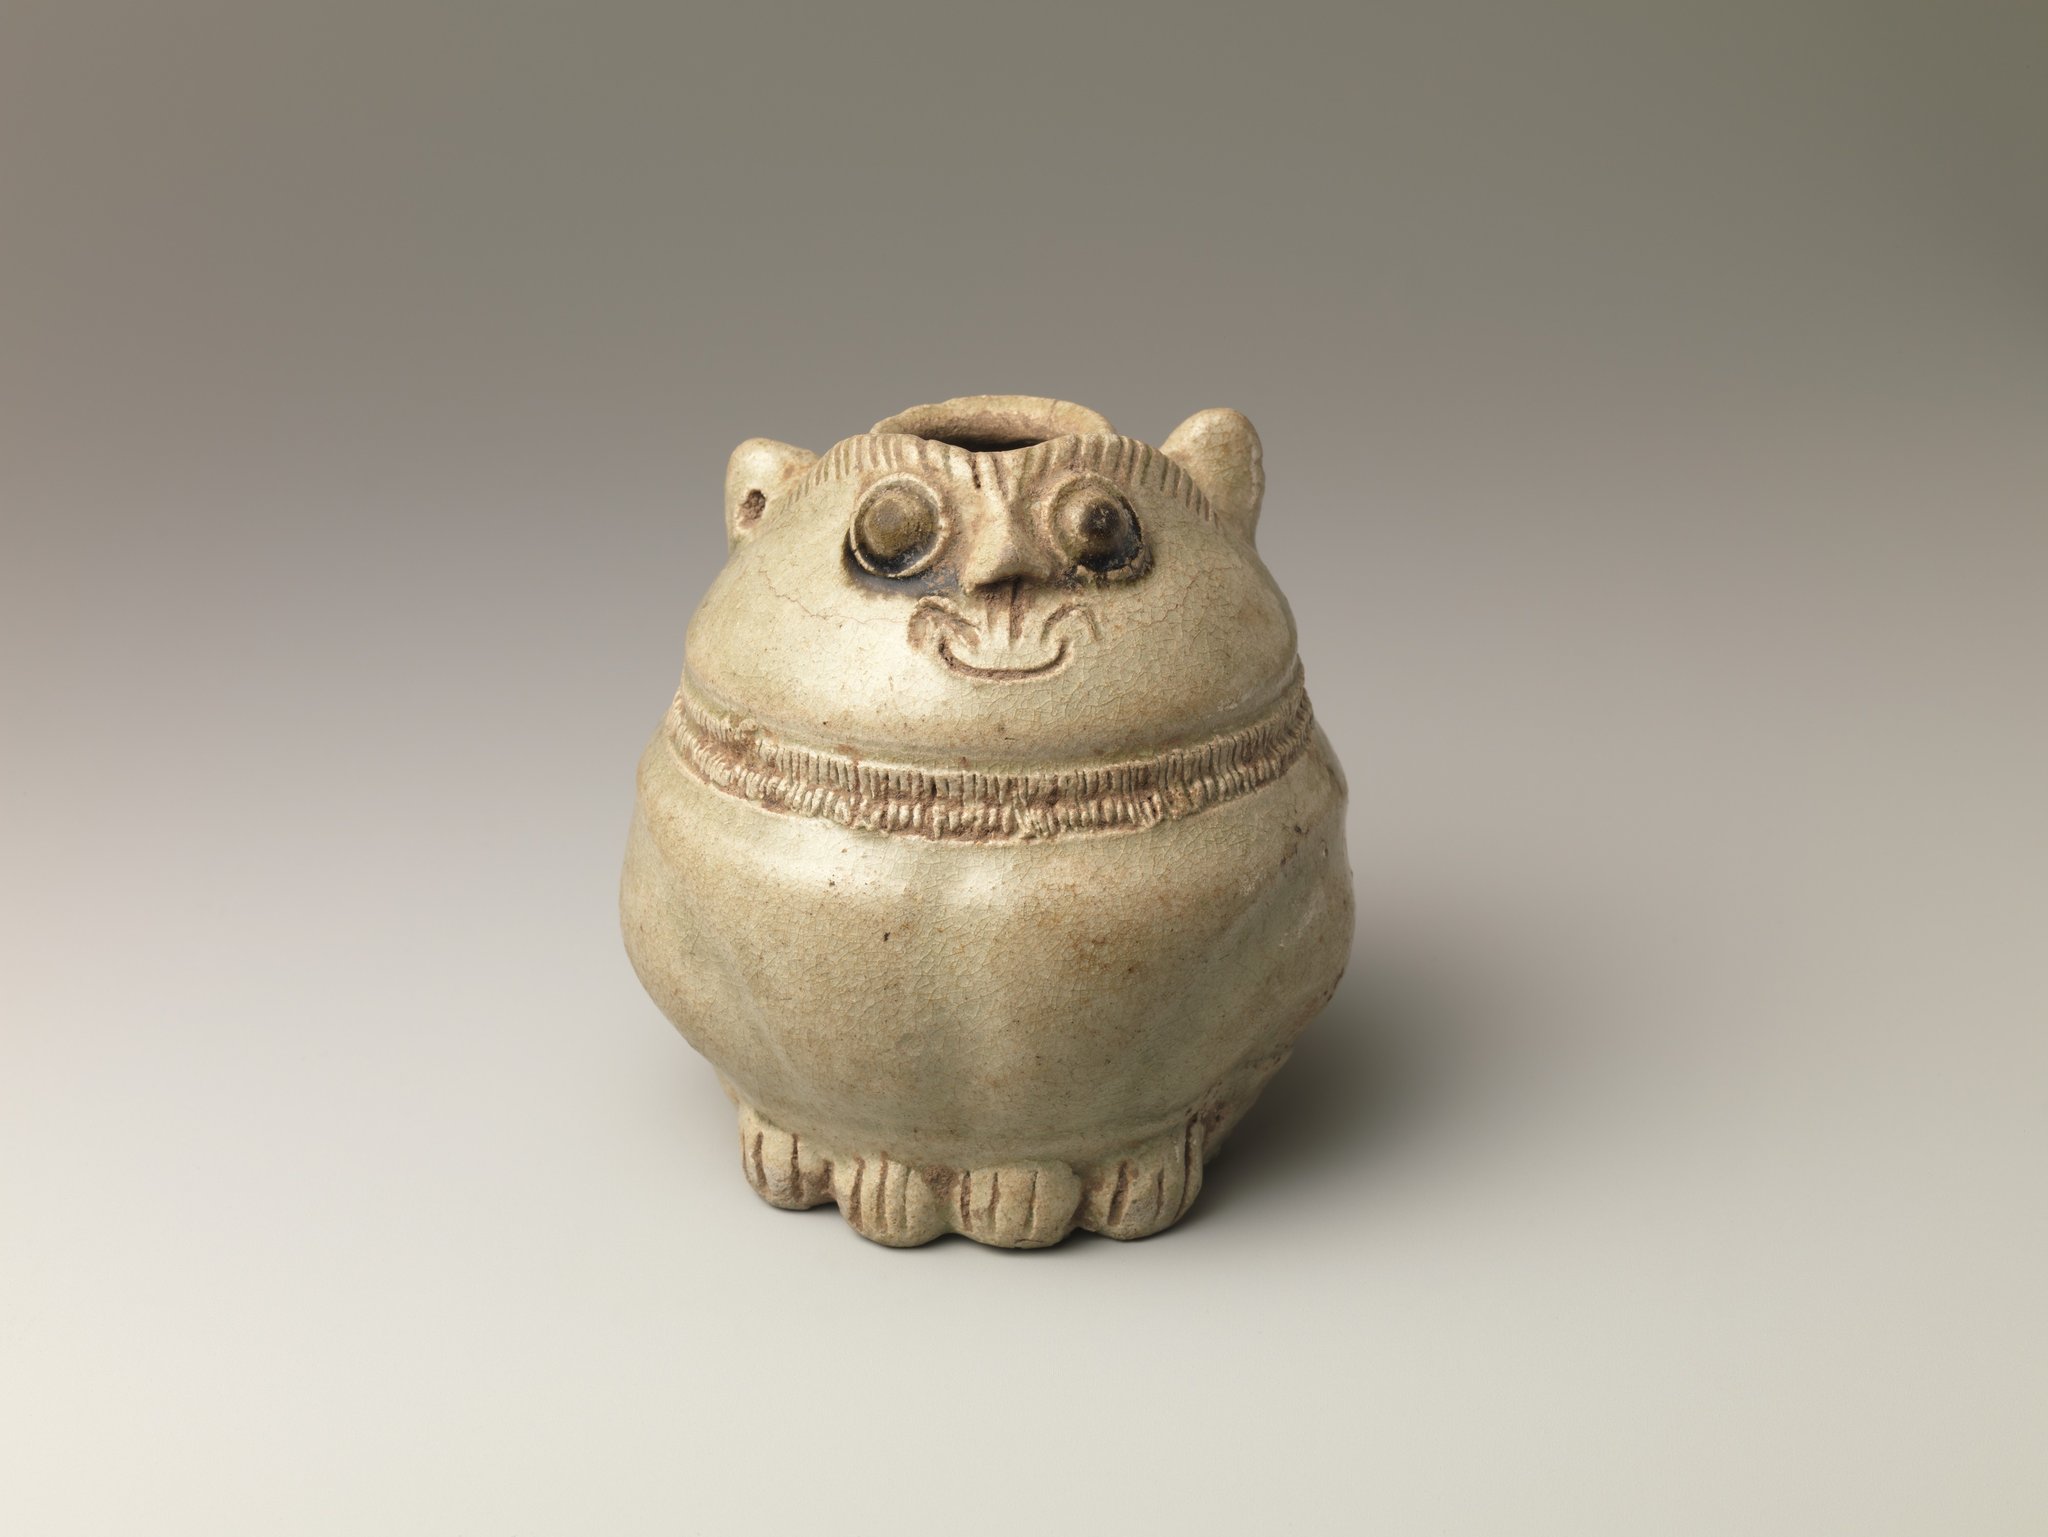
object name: lime pot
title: Lime Pot in the Shape of Cat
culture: thailand, buriram province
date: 1001-1200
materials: pottery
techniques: glazing, incising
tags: cats